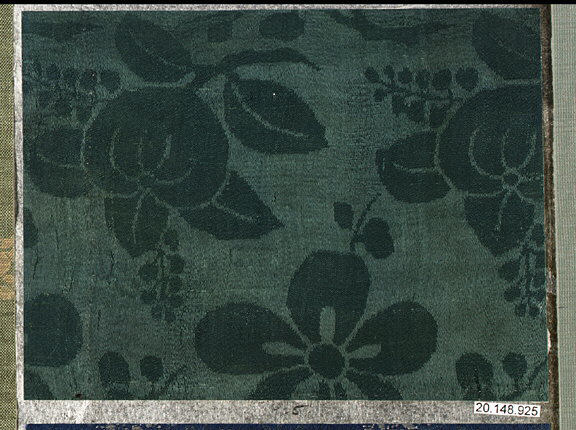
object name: piece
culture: japanese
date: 1701-1800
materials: silk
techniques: compound weave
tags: flowers